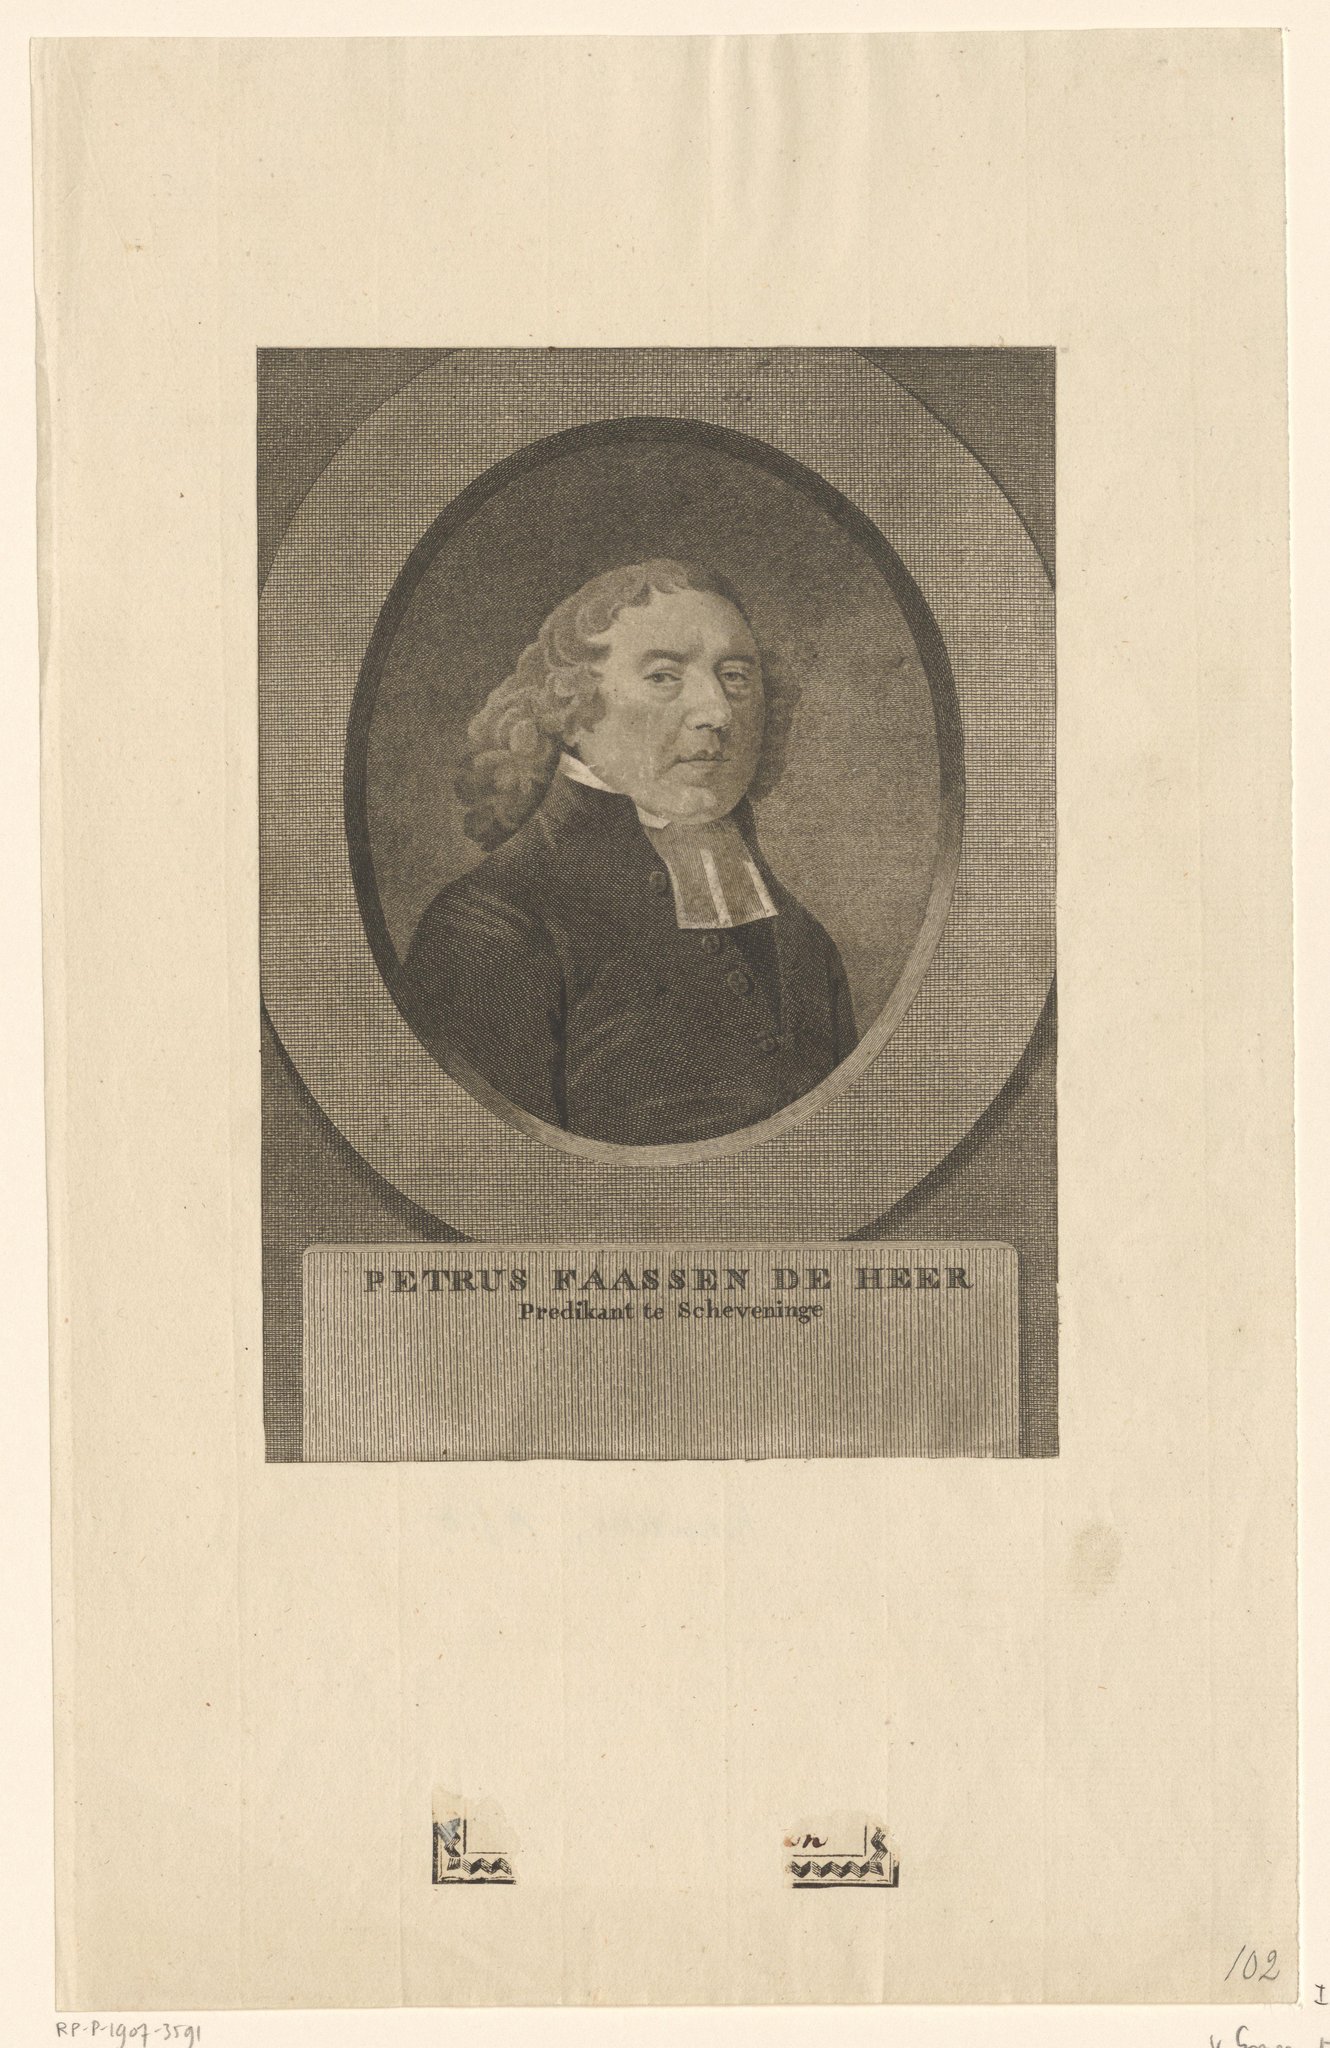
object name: print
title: Portret van Petrus Faassen de Heer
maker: Anonymous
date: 1799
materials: paper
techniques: aquatint, etching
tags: historical persons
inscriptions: collector's mark: Lugt 2228